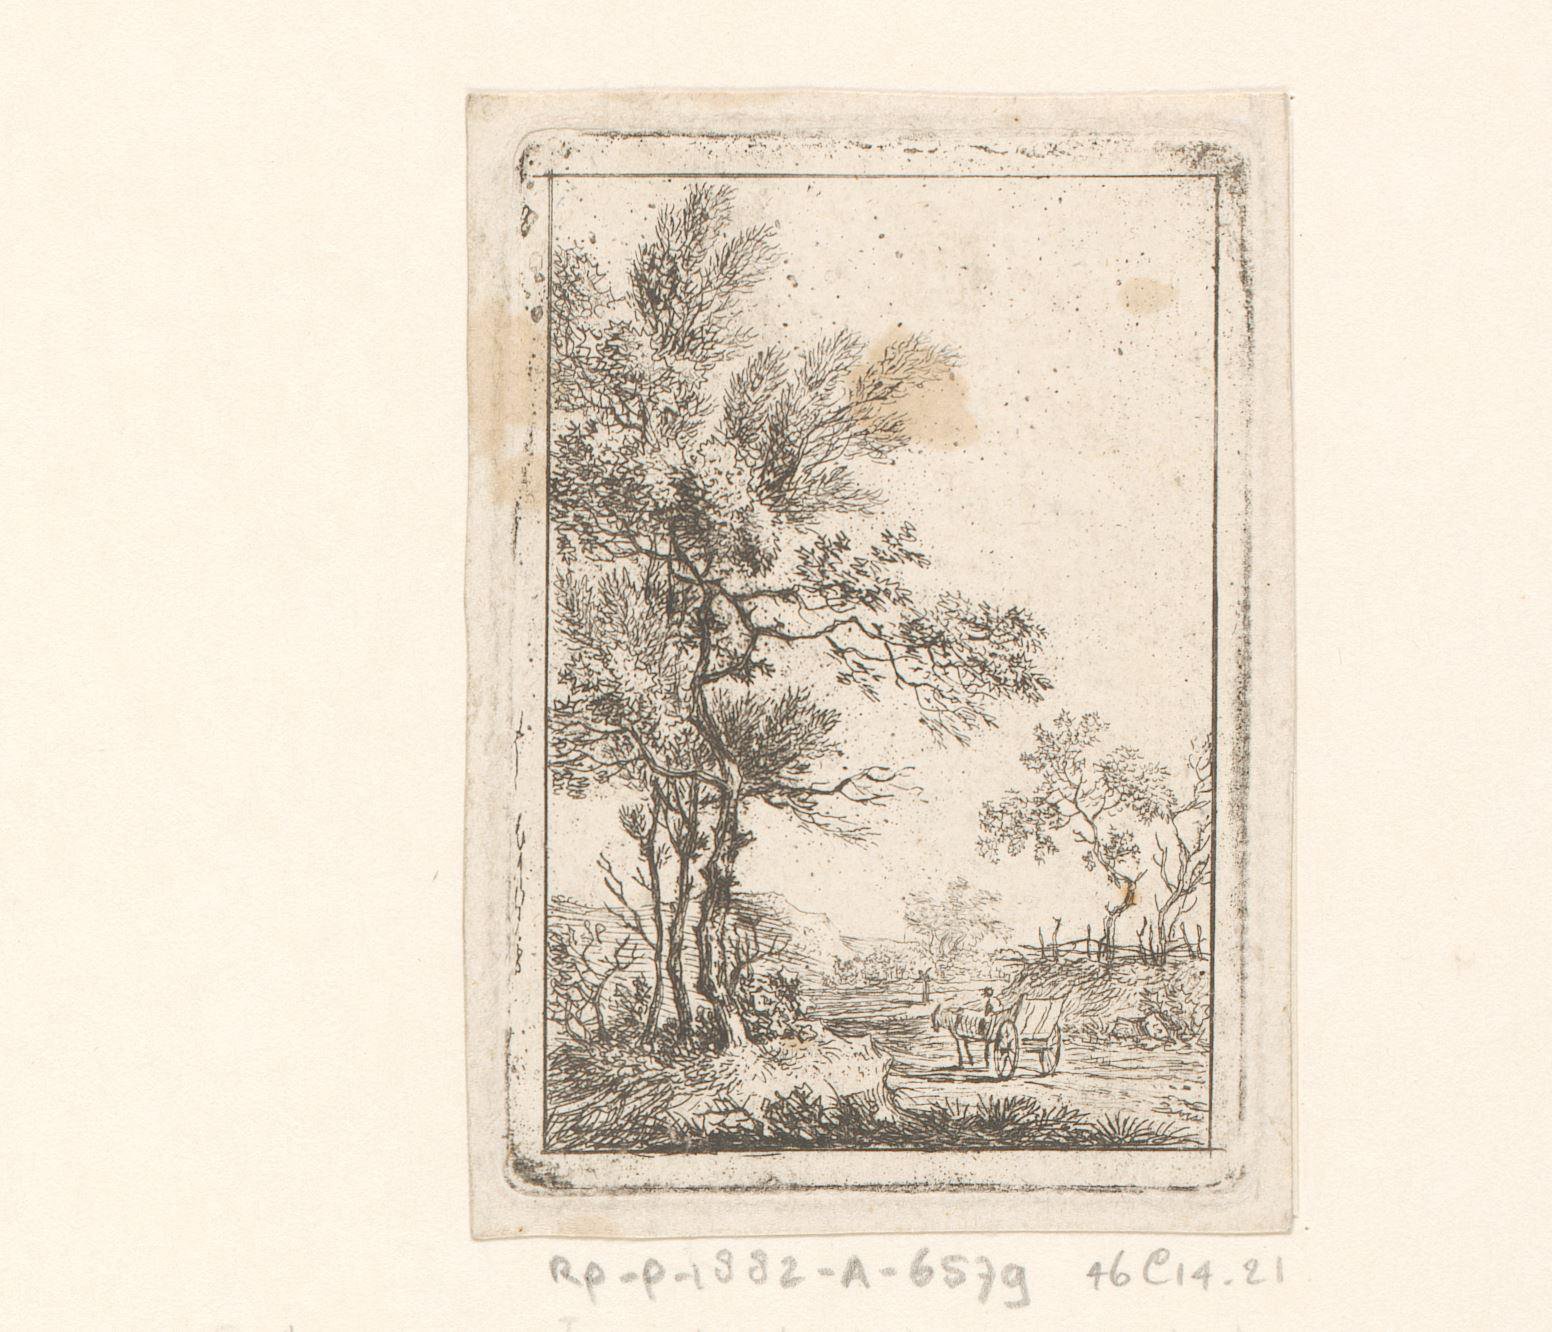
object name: print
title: Landschap met hoge boompartij en paard en wagen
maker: hermanus fock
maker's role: conservator, draughtsman, painter, print maker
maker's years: 1766-1822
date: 1776-1822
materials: paper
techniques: etching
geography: amsterdam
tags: trees, two-wheeled vehicle drawn by one animal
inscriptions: collector's mark: Lugt 2228